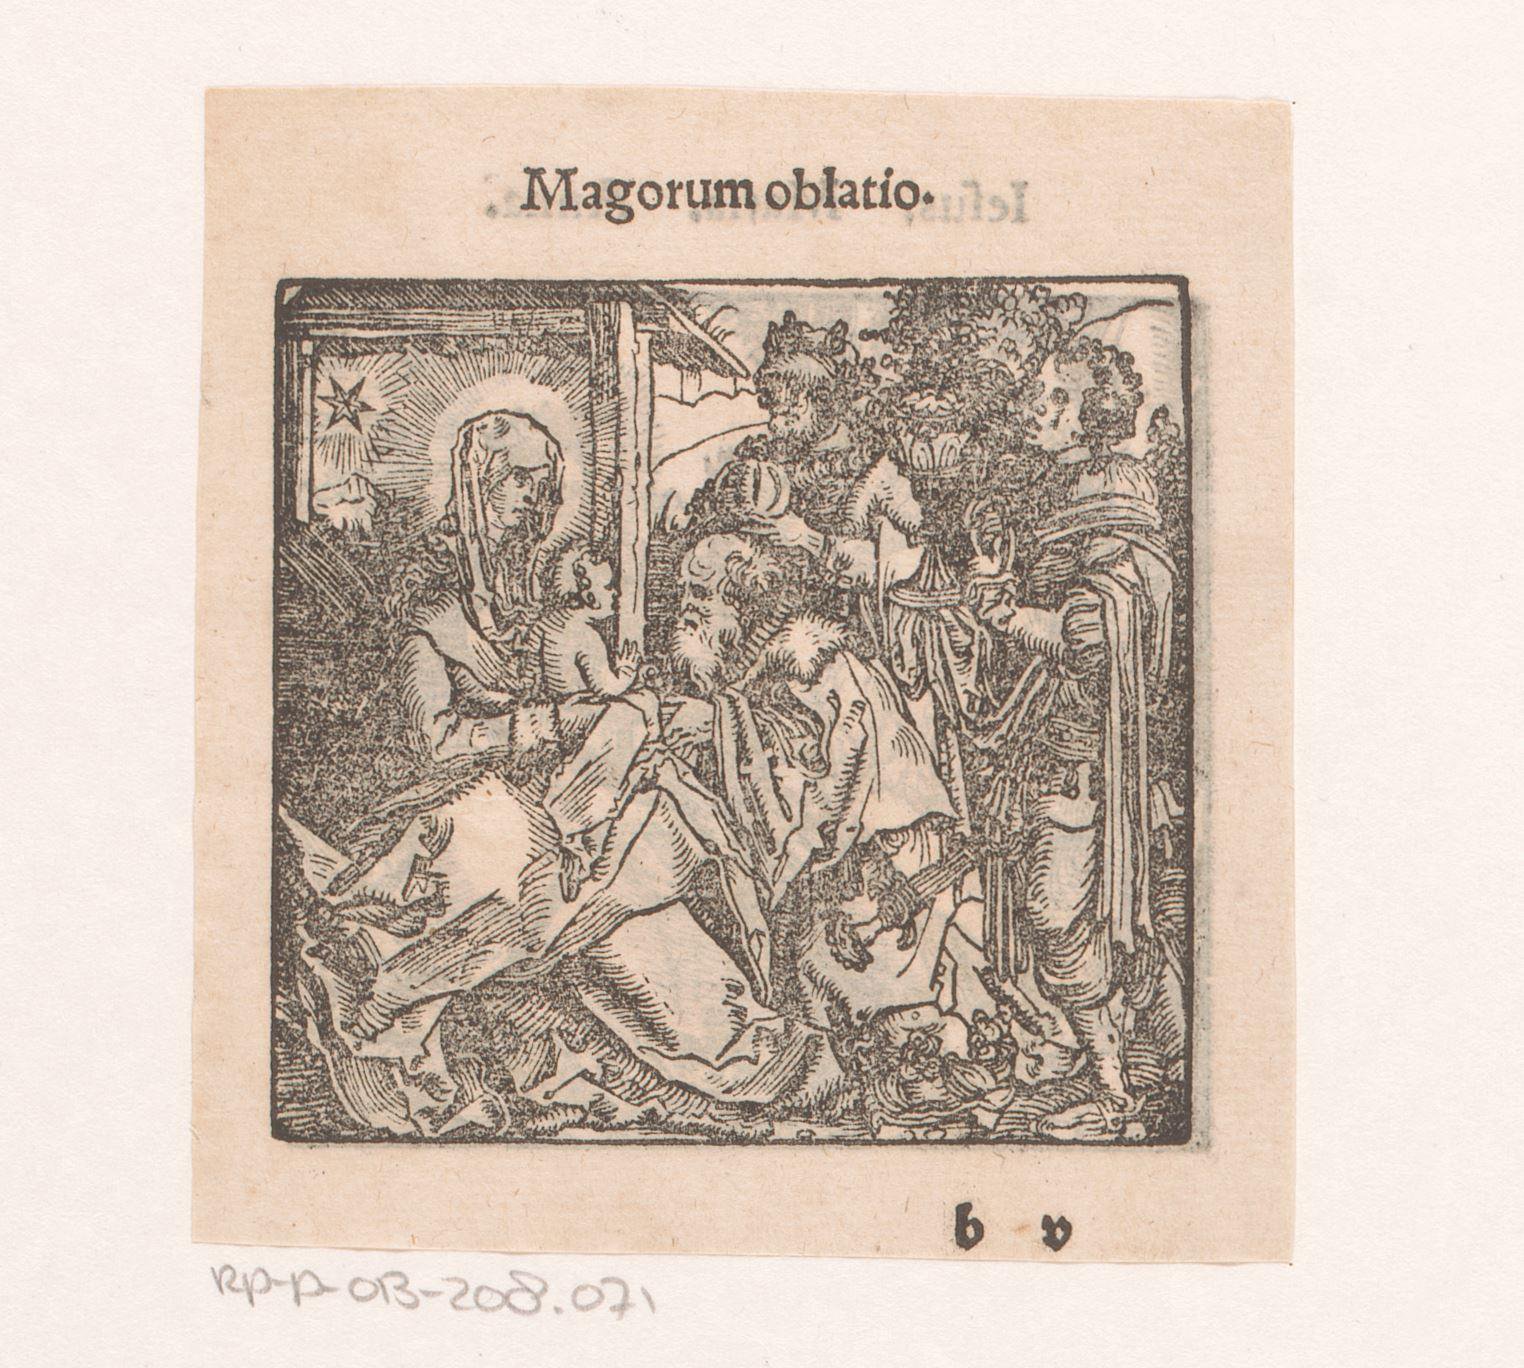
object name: book illustration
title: Aanbidding door de koningen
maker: Anonymous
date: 1600-1699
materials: paper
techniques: letterpress printing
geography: netherlands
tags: adoration of the kings: the wise men present their gifts to the christ-child (gold, frankincense and myrrh)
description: De drie koningen brengen hun geschenken en aanbidden het Christuskind, dat op schoot zit bij Maria. Een koning knielt voor het Kind.